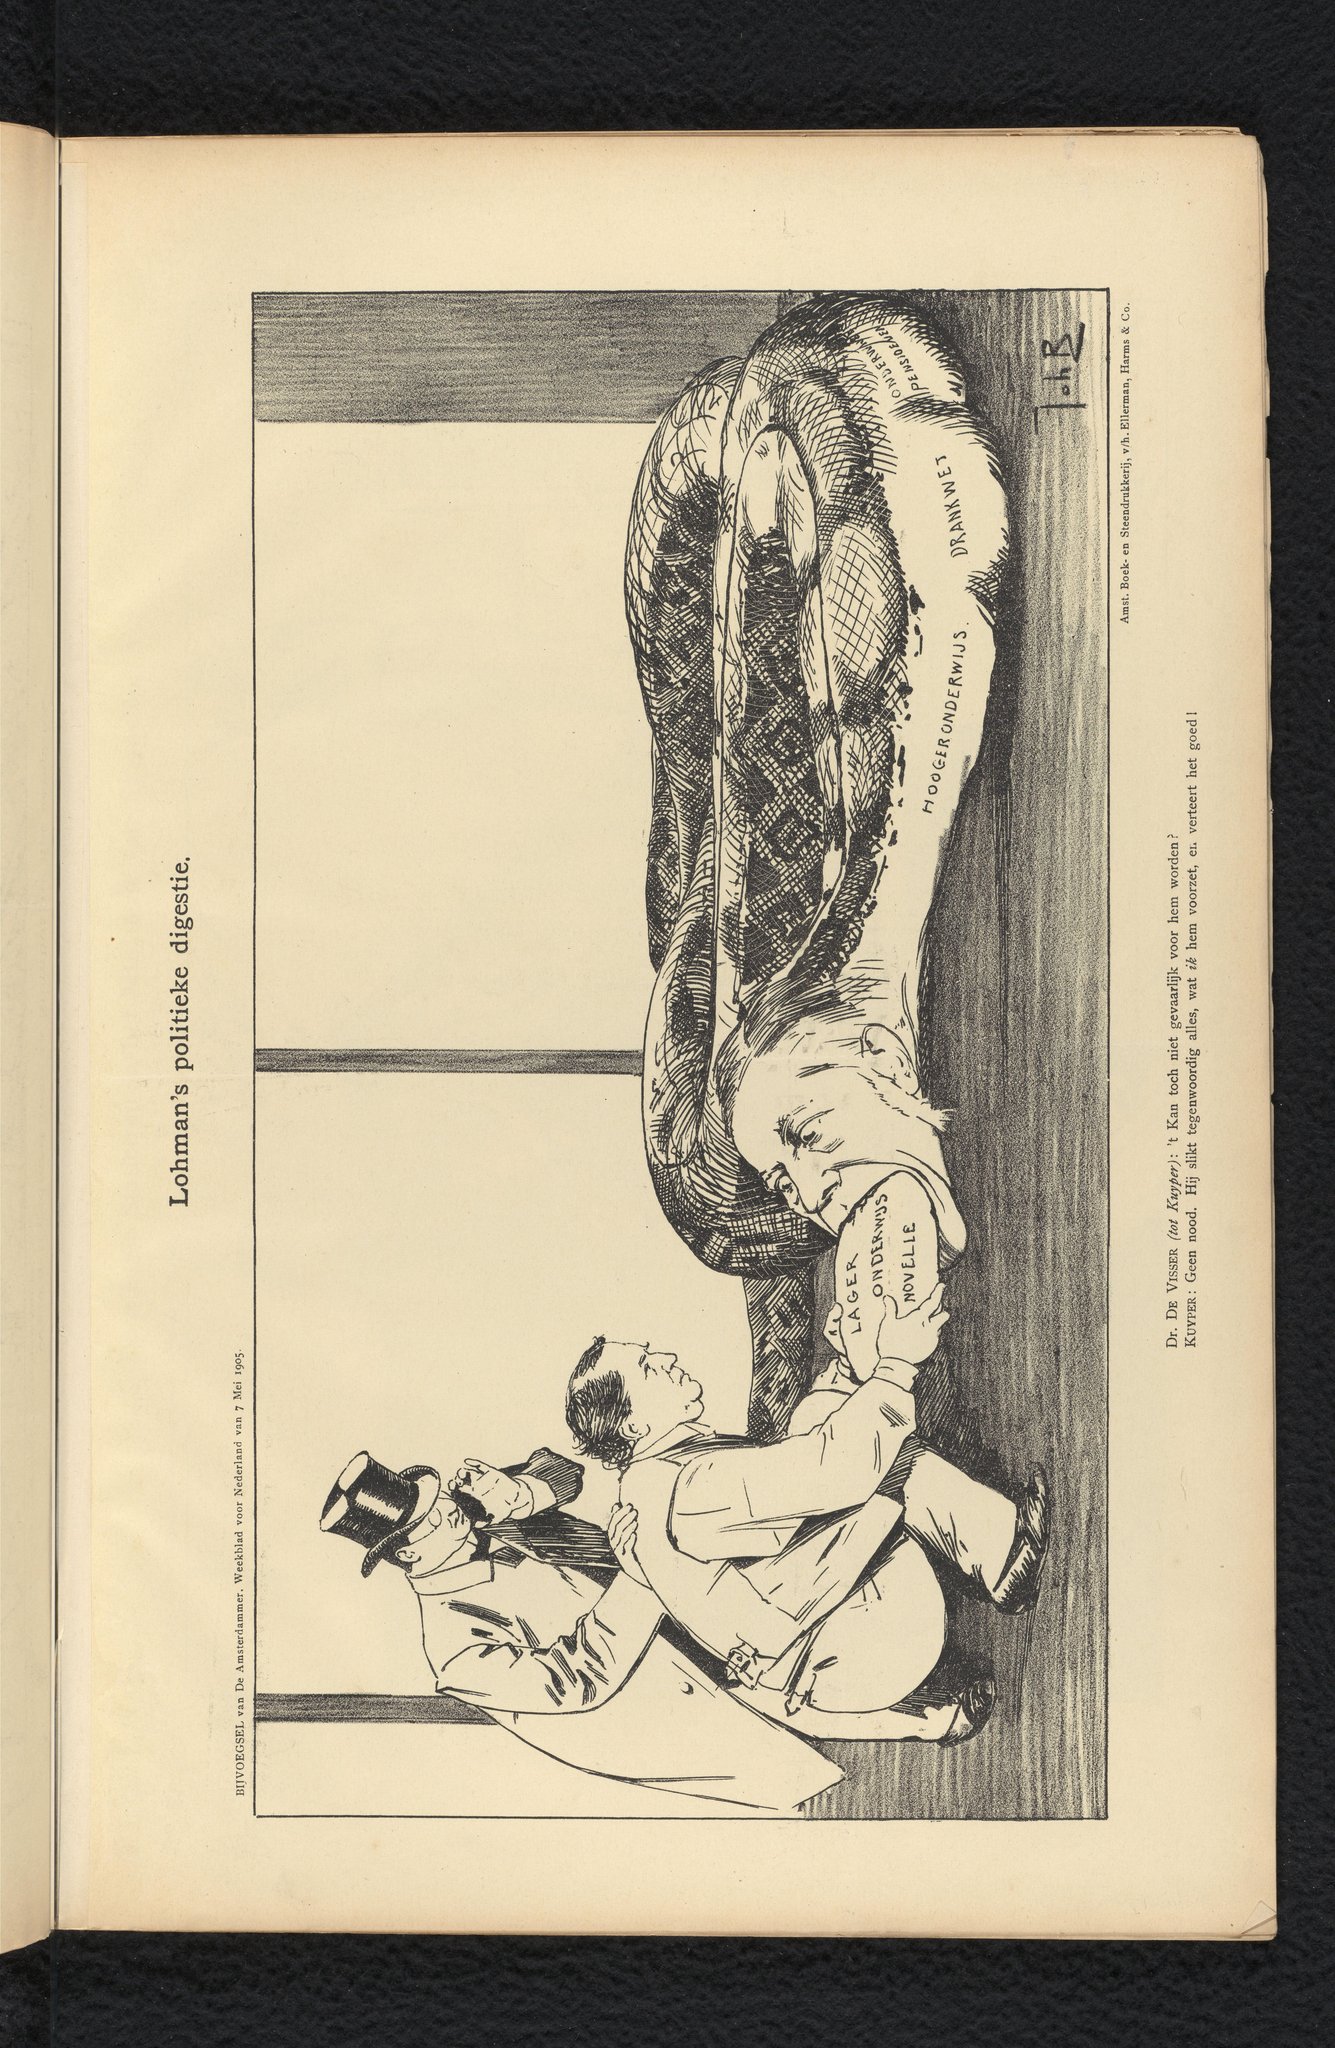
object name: cartoon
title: Lohman's politieke digestie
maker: johan braakensiek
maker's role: draughtsman, print maker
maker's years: 1858-1940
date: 1905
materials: paper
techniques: lithograph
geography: amsterdam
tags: jonkheer alexander frederik de savornin lohman, abraham kuyper, utrecht, the hague, snakes, political caricatures and satires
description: Onder toeziend oog van kamerlid De Visser voert premier Kuyper de enorme slang Lohman een groot pakket over lager onderwijs. Volgens Kuyper is er geen gevaar en slikt Lohman alles wat hem voorgezet wordt.